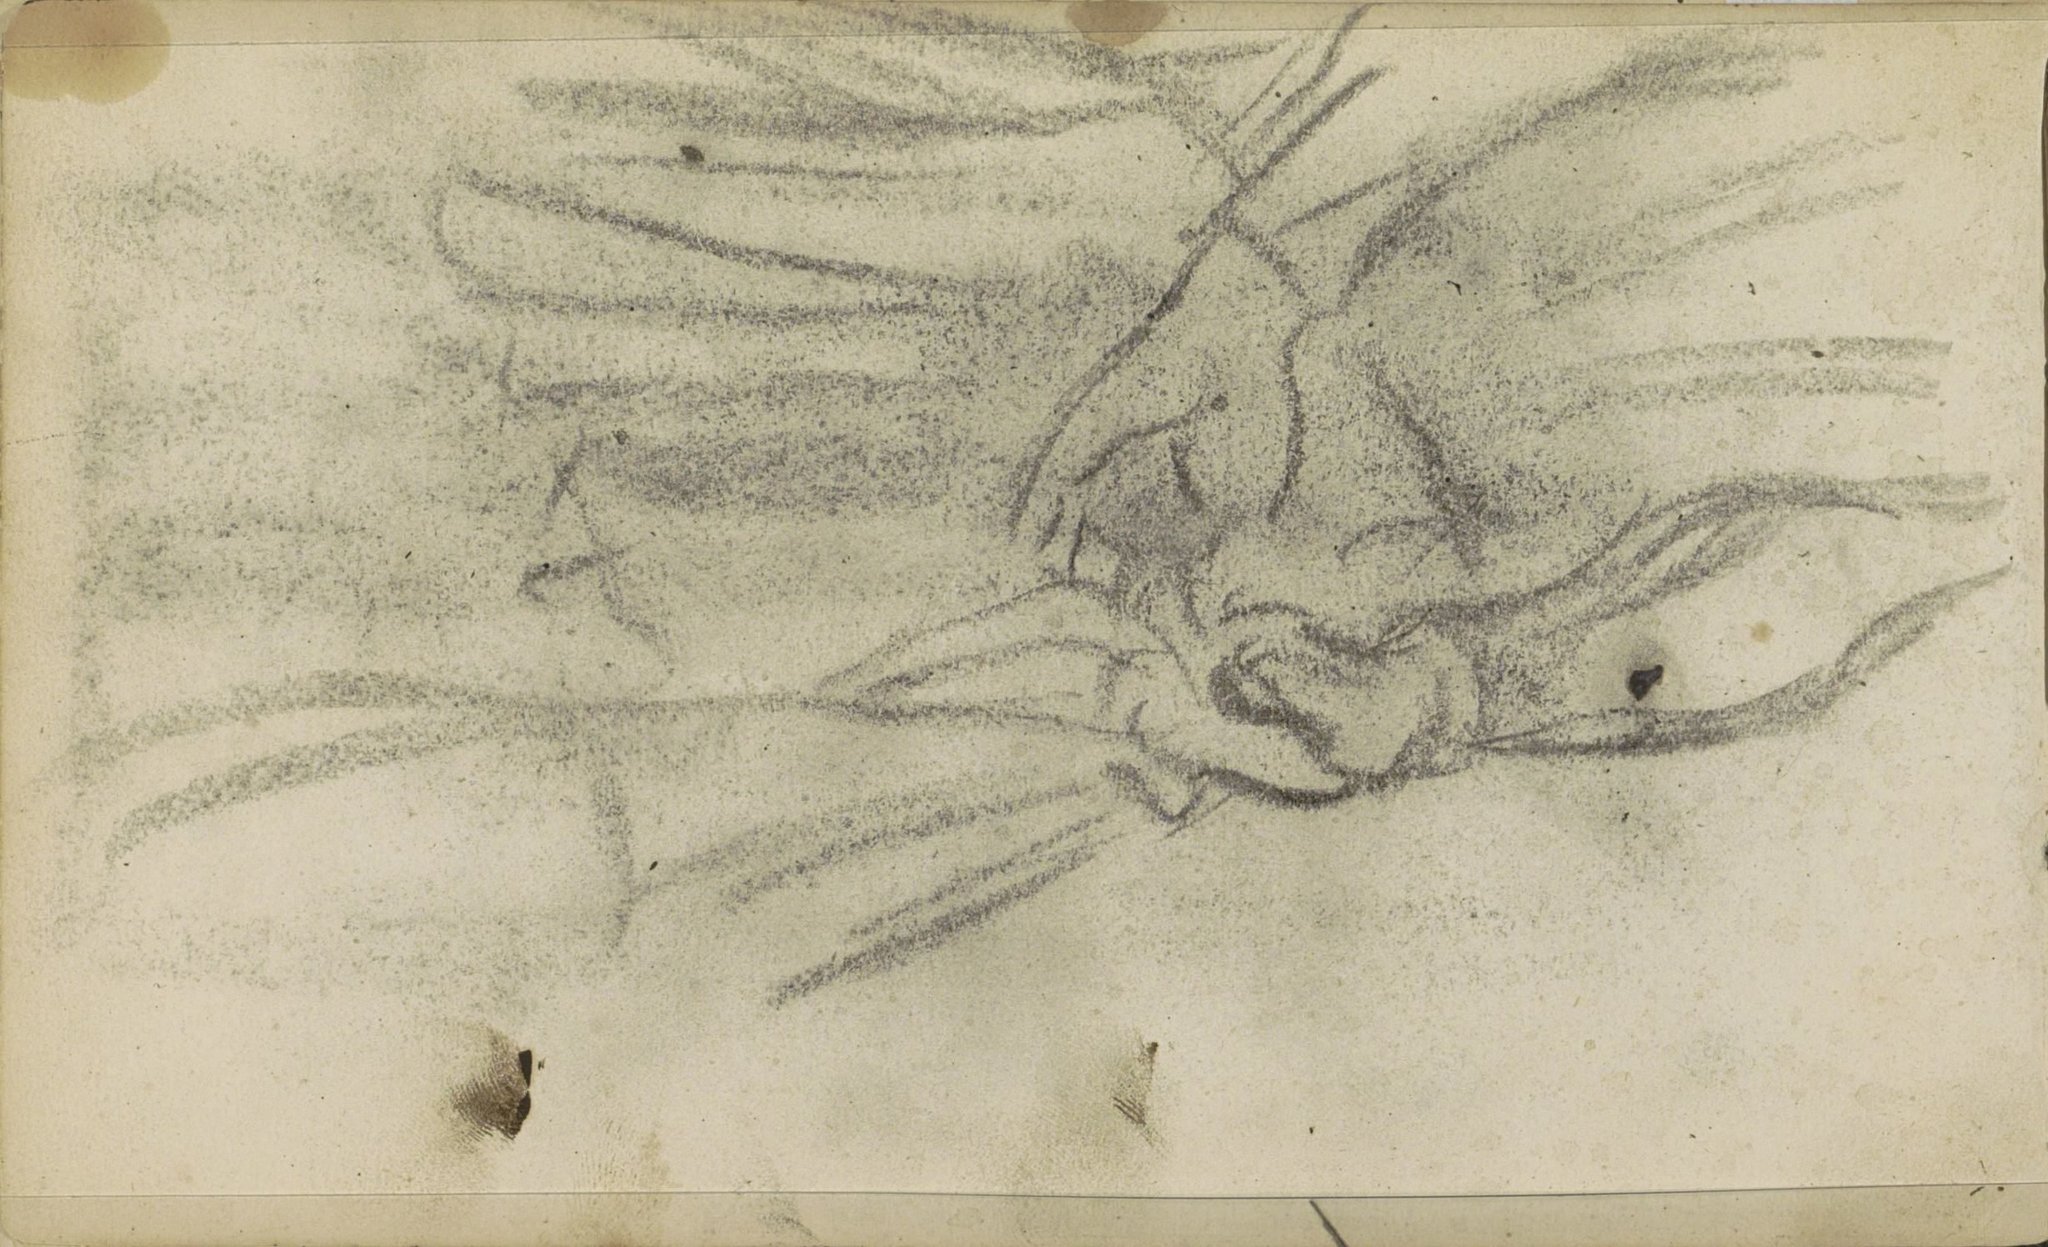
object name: sketchbook leaf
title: Vrouw, staand met de handen achter de rug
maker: jozef israëls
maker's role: draughtsman, painter, print maker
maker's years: 1824-1911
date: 1834-1911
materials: chalk, paper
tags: sailing-ship, sailing-boat, arm or hand bent behind the body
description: De vrouw heeft een doek, mogelijk een zakdoek in haar handen. Blad 15 verso uit een schetsboek met 42 bladen.